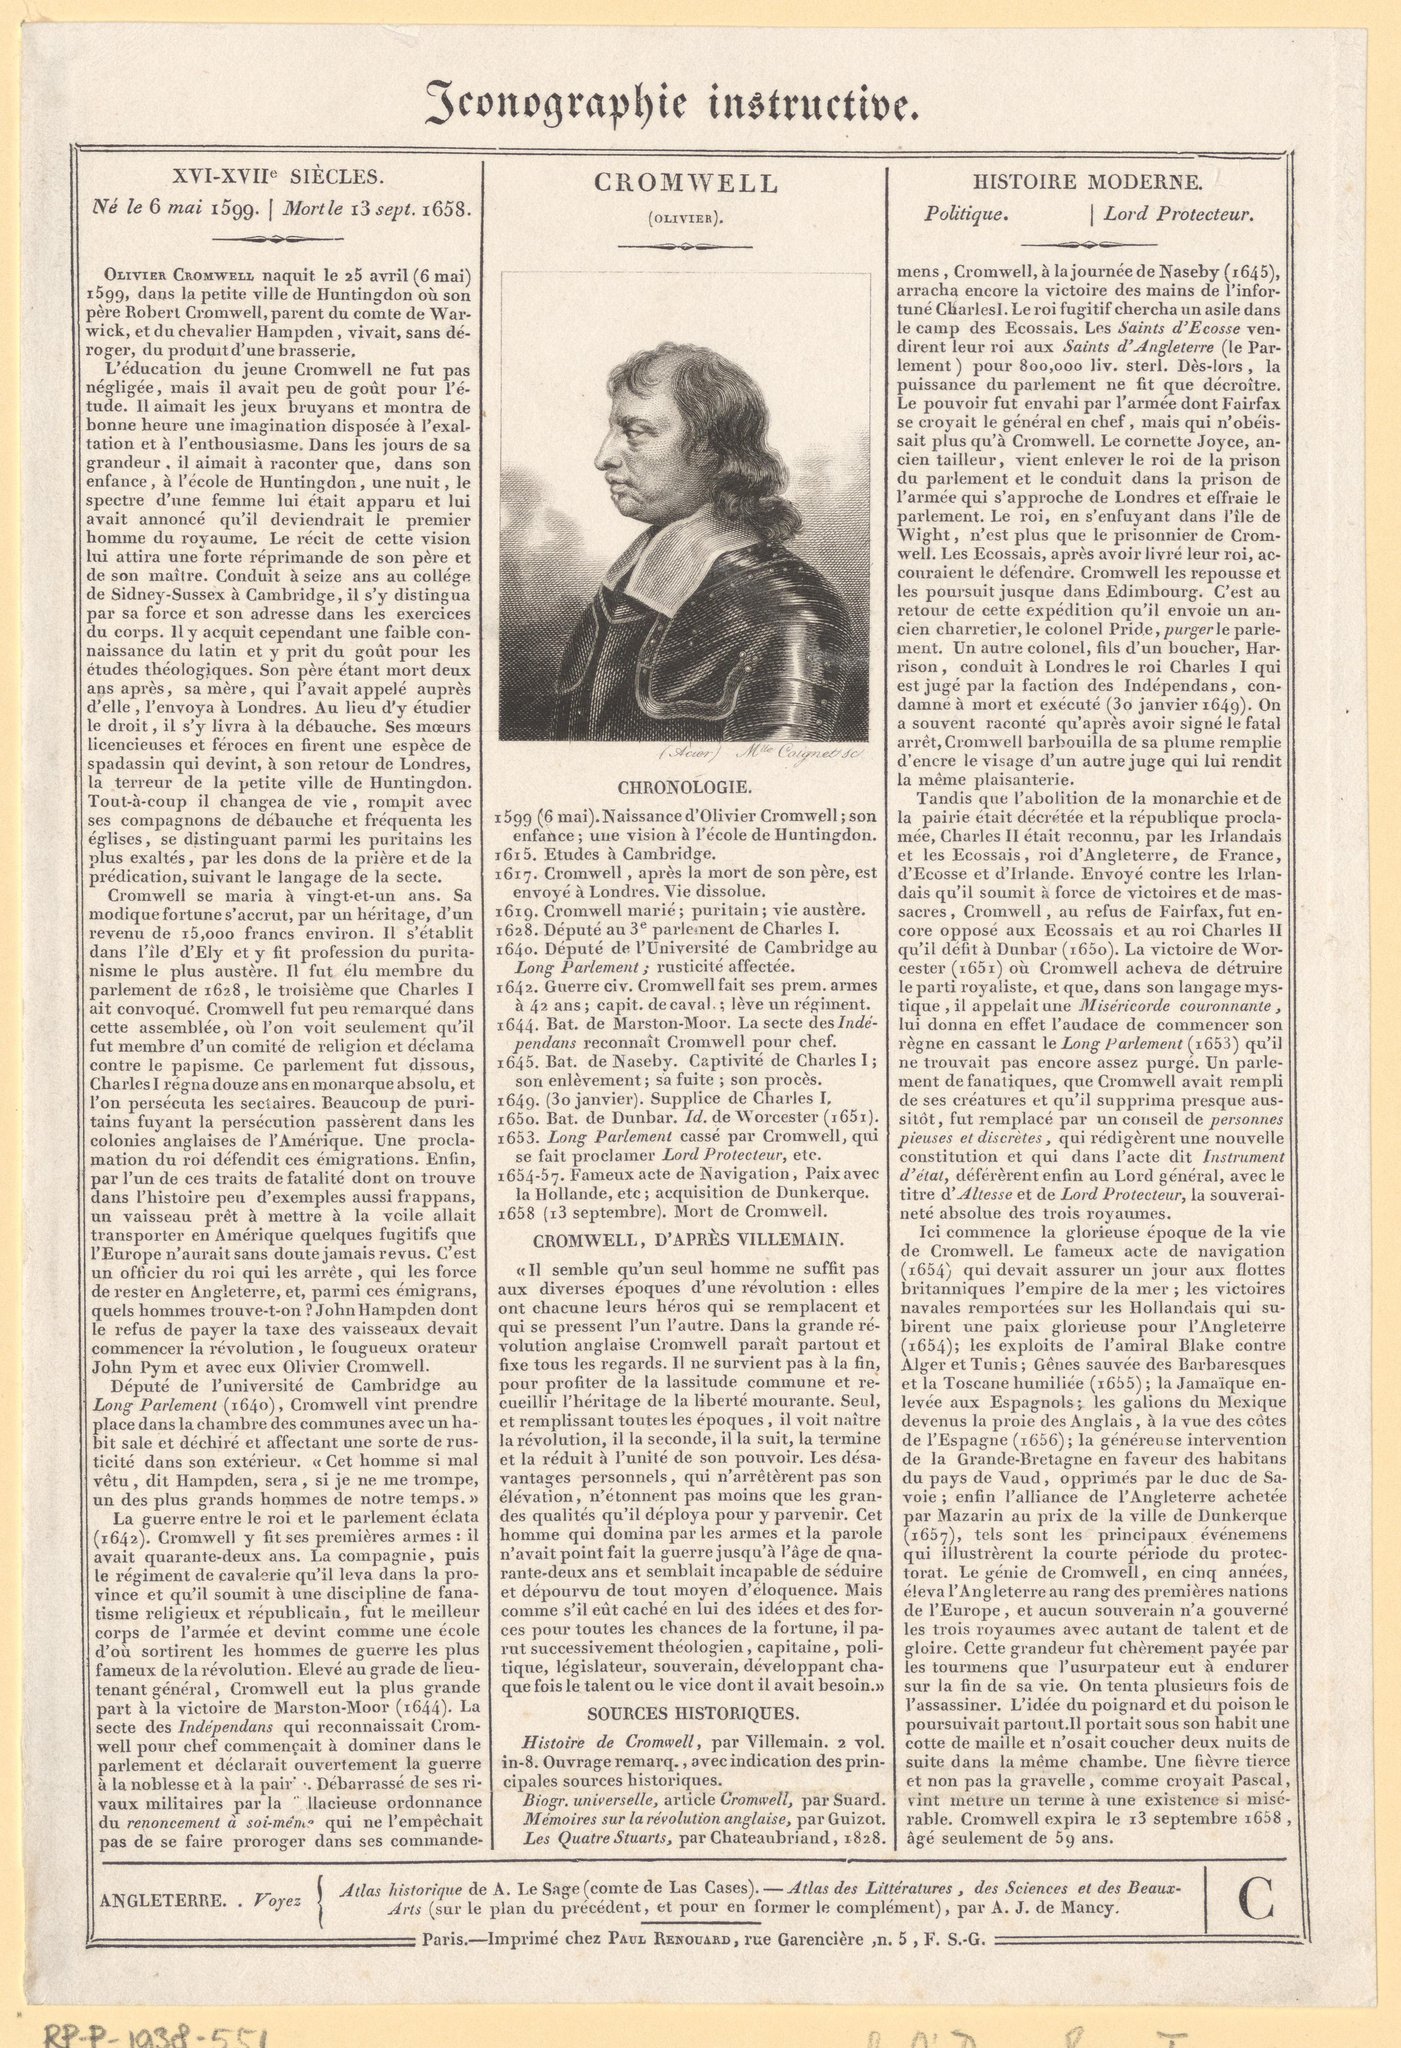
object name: print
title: Galerie historique, collection de 200 portraits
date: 1839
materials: paper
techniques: engraving, letterpress printing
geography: paris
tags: london, oliver cromwell, historical persons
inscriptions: collector's mark: Lugt 2228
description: Prent uit: Galerie historique, collection de 200 portraits des personnages les plus célèbres. Parijs: Jean François Bènard, 1839.